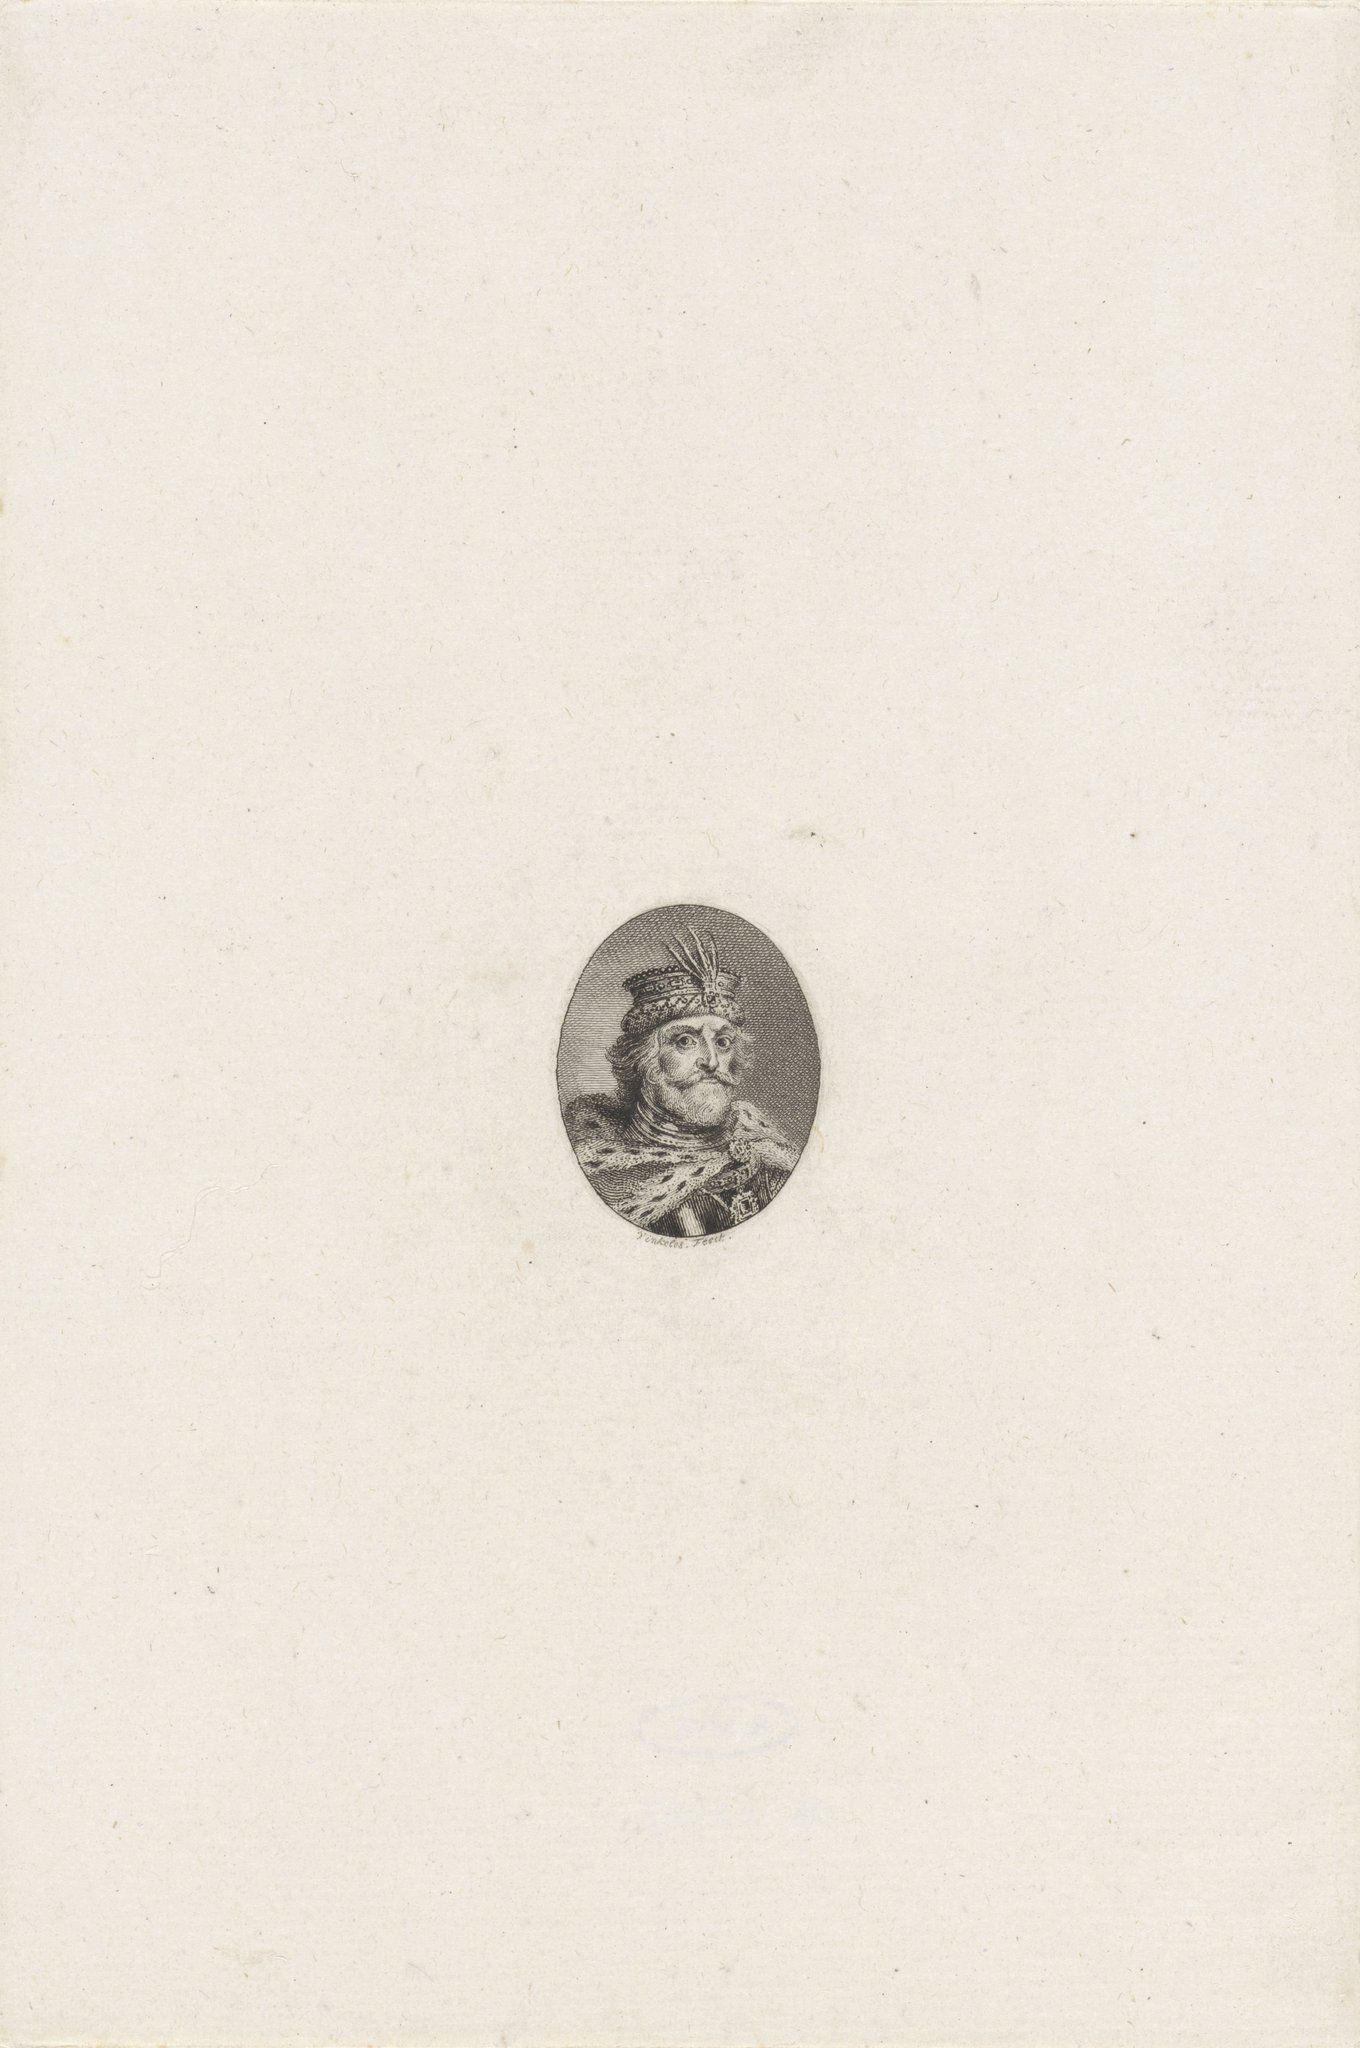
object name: print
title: Portret van Floris V, graaf van Holland en Zeeland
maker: reinier vinkeles (i)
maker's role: draughtsman, print maker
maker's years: 1741-1816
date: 1808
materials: paper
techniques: etching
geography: amsterdam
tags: leiden, floris v (graaf van holland en zeeland)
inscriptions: collector's mark: Lugt 2228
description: Latere staat gebruikt als titelpagina voor: Bilderdijk, Willem. Floris de Vijfde treurspel. Amsterdam: Johannes Allart, 1808.